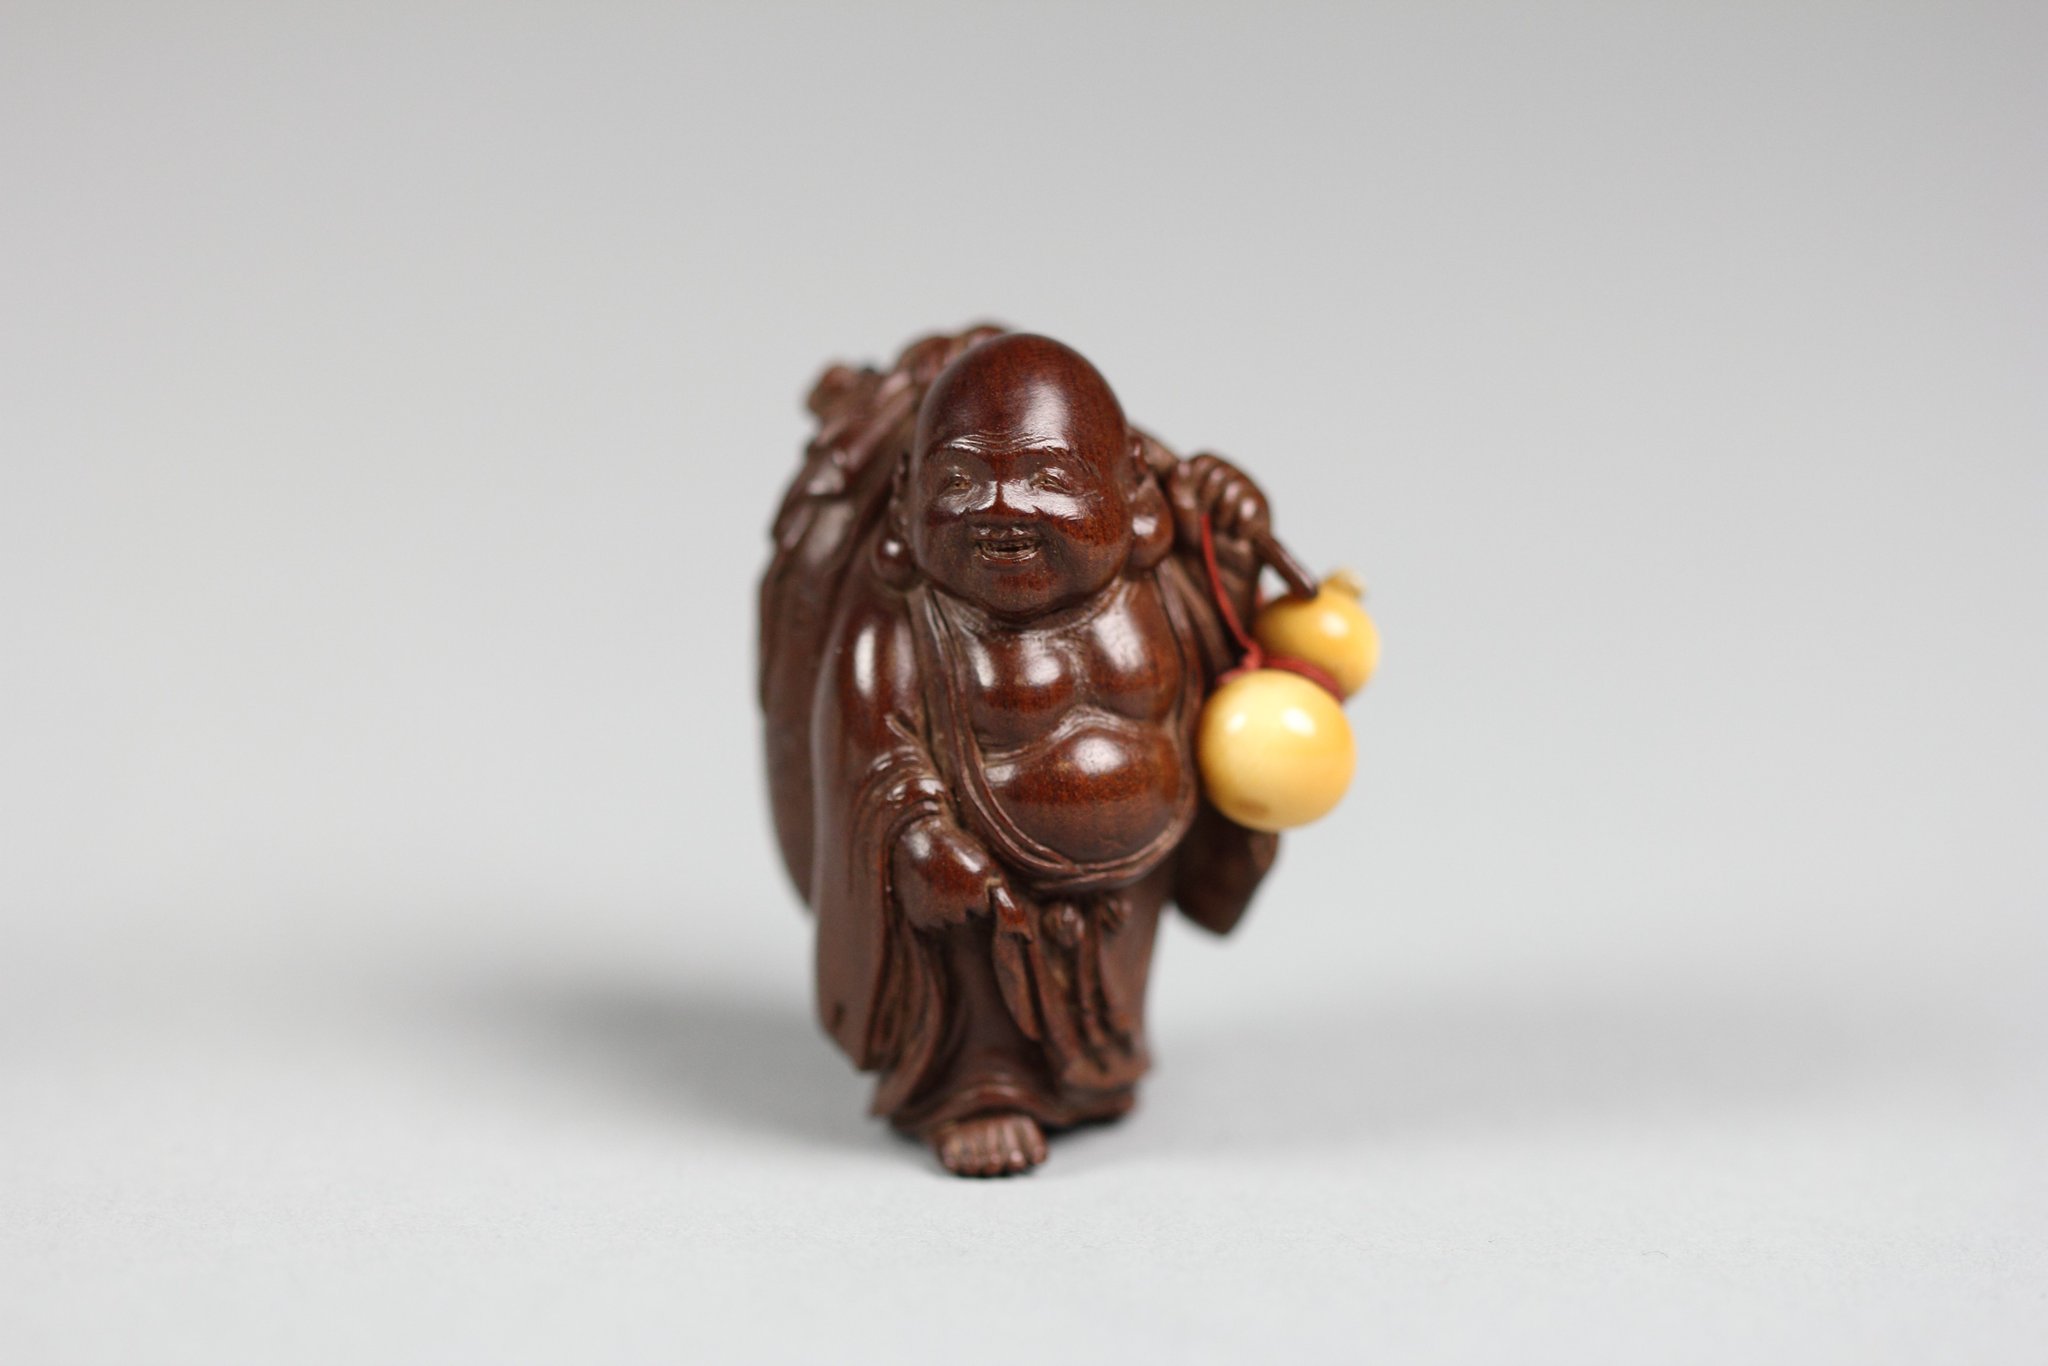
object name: netsuke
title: Netsuke of Hotei with Bag and Gourd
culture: japanese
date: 1801-1900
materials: wood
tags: men,gourds